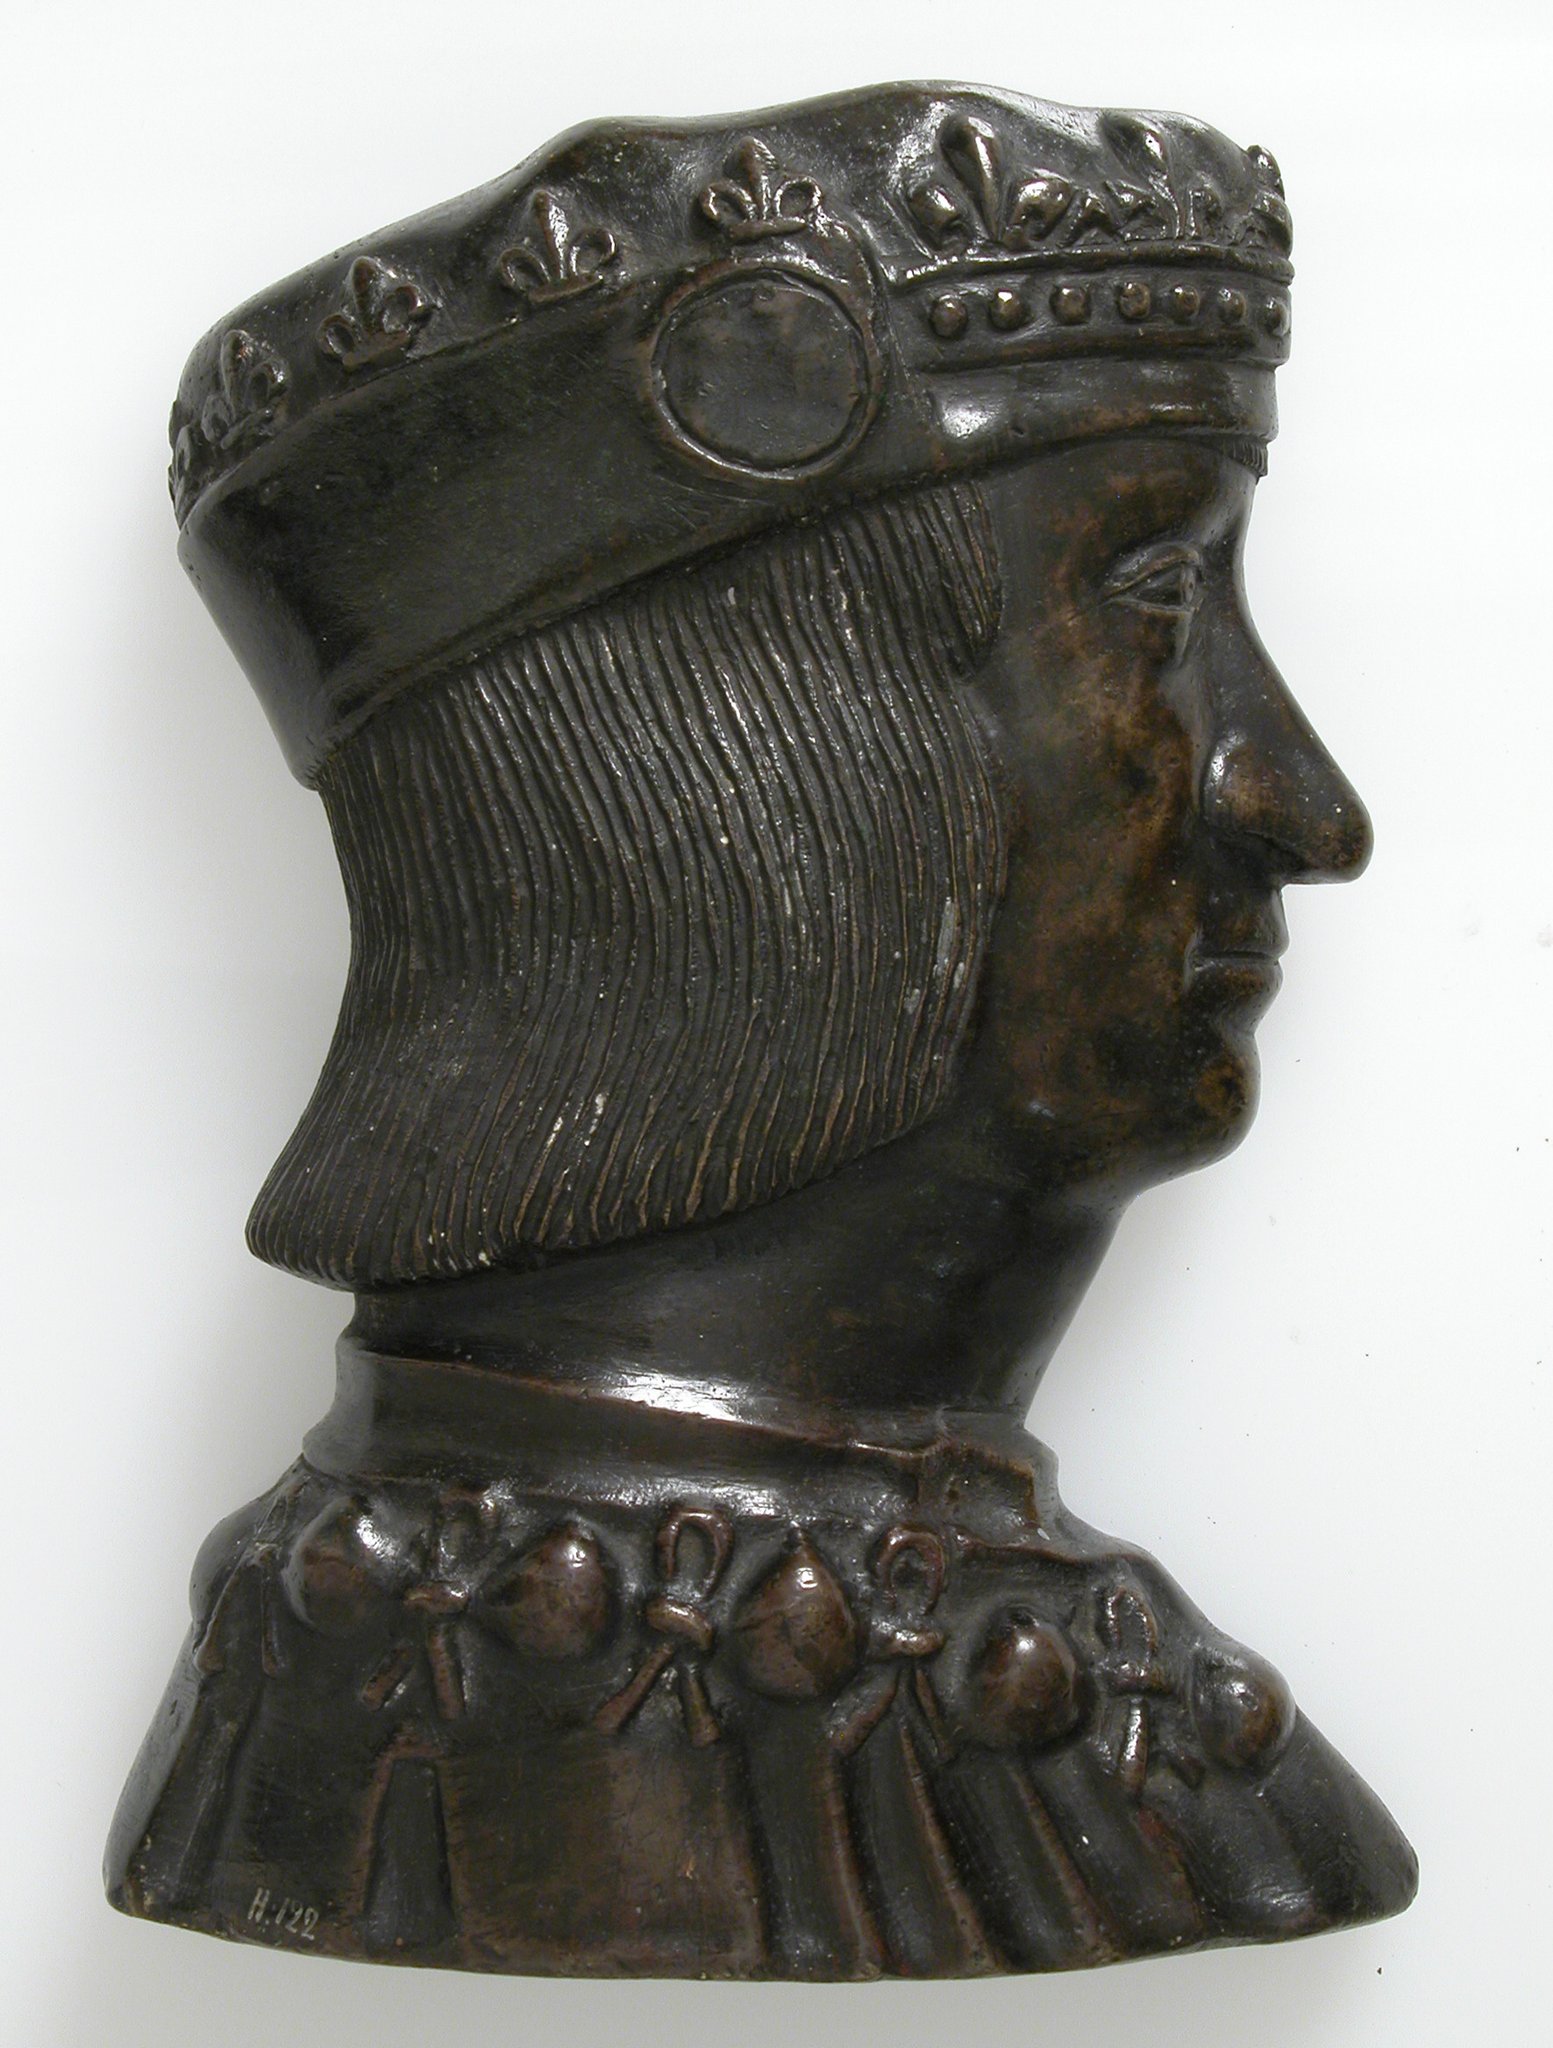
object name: plaque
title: Plaque, Louis XII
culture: french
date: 1500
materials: copper alloy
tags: profiles